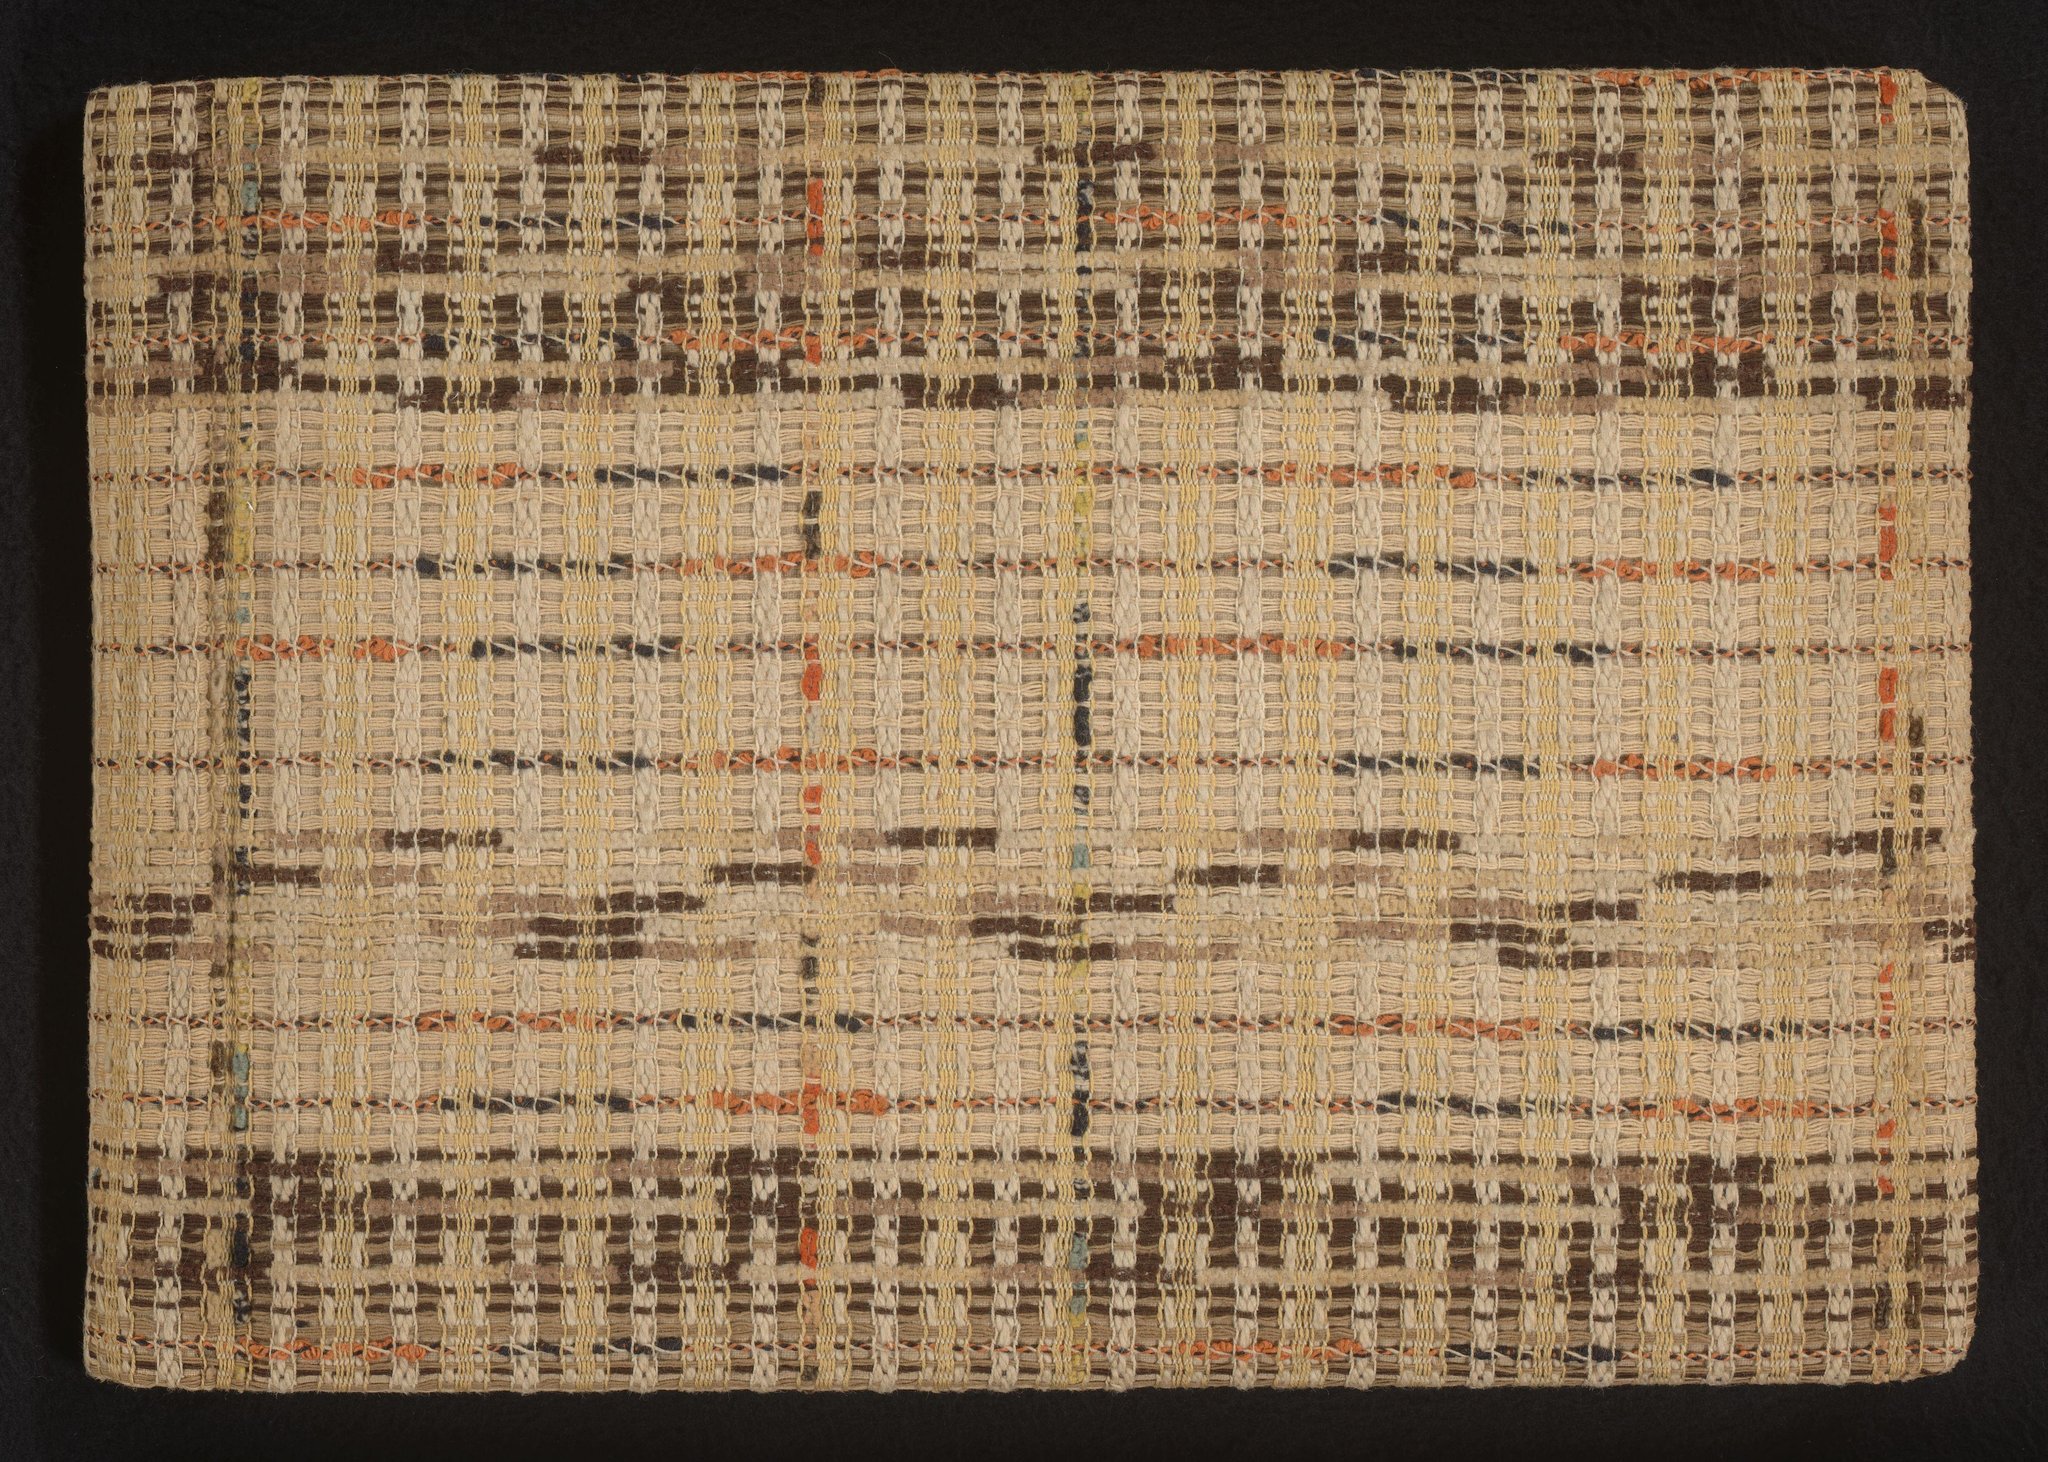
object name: photograph album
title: Fotoalbum Duitse bezetting van Nederland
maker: Anonymous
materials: cardboard, paper, photographic support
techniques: gelatin silver print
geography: germany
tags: the hague, rotterdam, brussels, amsterdam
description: Duits militair fotoalbum uit de Tweede Wereldoorlog met een stoffen omslag. Hierin 22 bruin kartonnen binnenbladen, waartussen pergamijn waarop vlinders, met ijzeren ringband in omslag gebonden. Het album bevat 187 zwart-wit foto's van onder andere een kazerne in Duitsland, mannen met scheppen (Reichsarbeitsdienst?), het strand, gebombardeerde steden (Rotterdam) en bruggen, de pier bij Scheveningen, Binnenhof in Den Haag, Raad van Arbeid, prentjes van gebouwen uit Brussel, verblijf in een ziekenhuis, het Rokin, Centraal Station en rondvaartboot in Amsterdam, Duitse oorlogsgraven. 4 Bladen blanco.